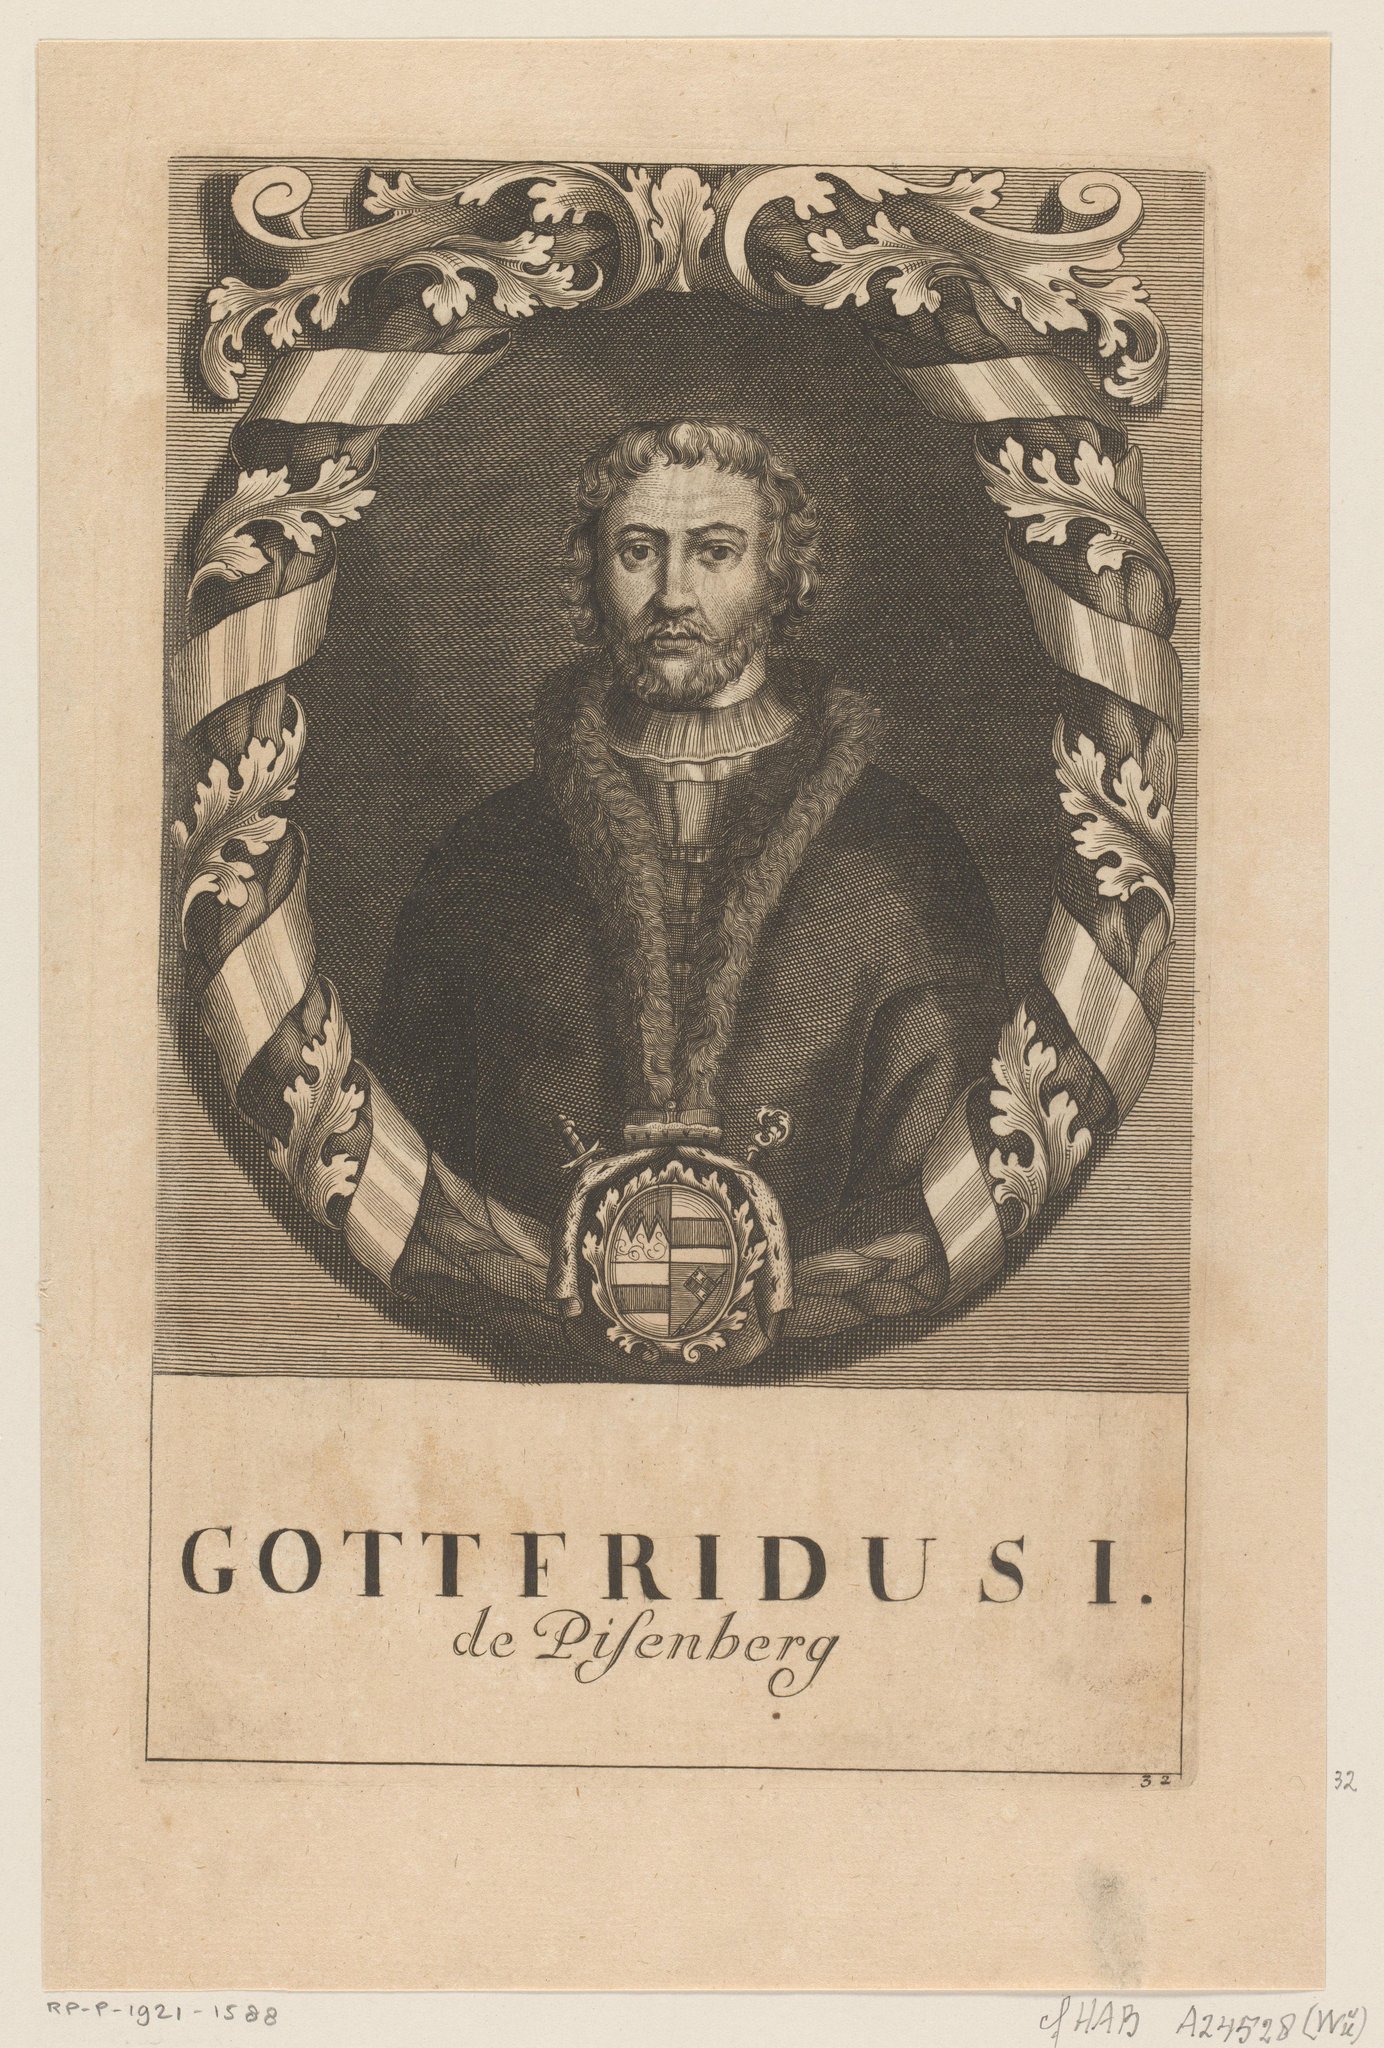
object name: print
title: Portret van Gottfried I von Spitzenstein-Helfenstein, bisschop van Würzburg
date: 1713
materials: paper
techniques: engraving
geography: frankfurt am main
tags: archbishop, bishop, etc. (roman catholic), historical persons, armorial bearing, heraldry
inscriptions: collector's mark: Lugt 2233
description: Prent uit: Ludewig, Johann Peter von. Geschicht-Schreiber von dem Bischoffthum Wirtzburg (...). Frankfurt am Main: Thomas Fritsch, 1713.